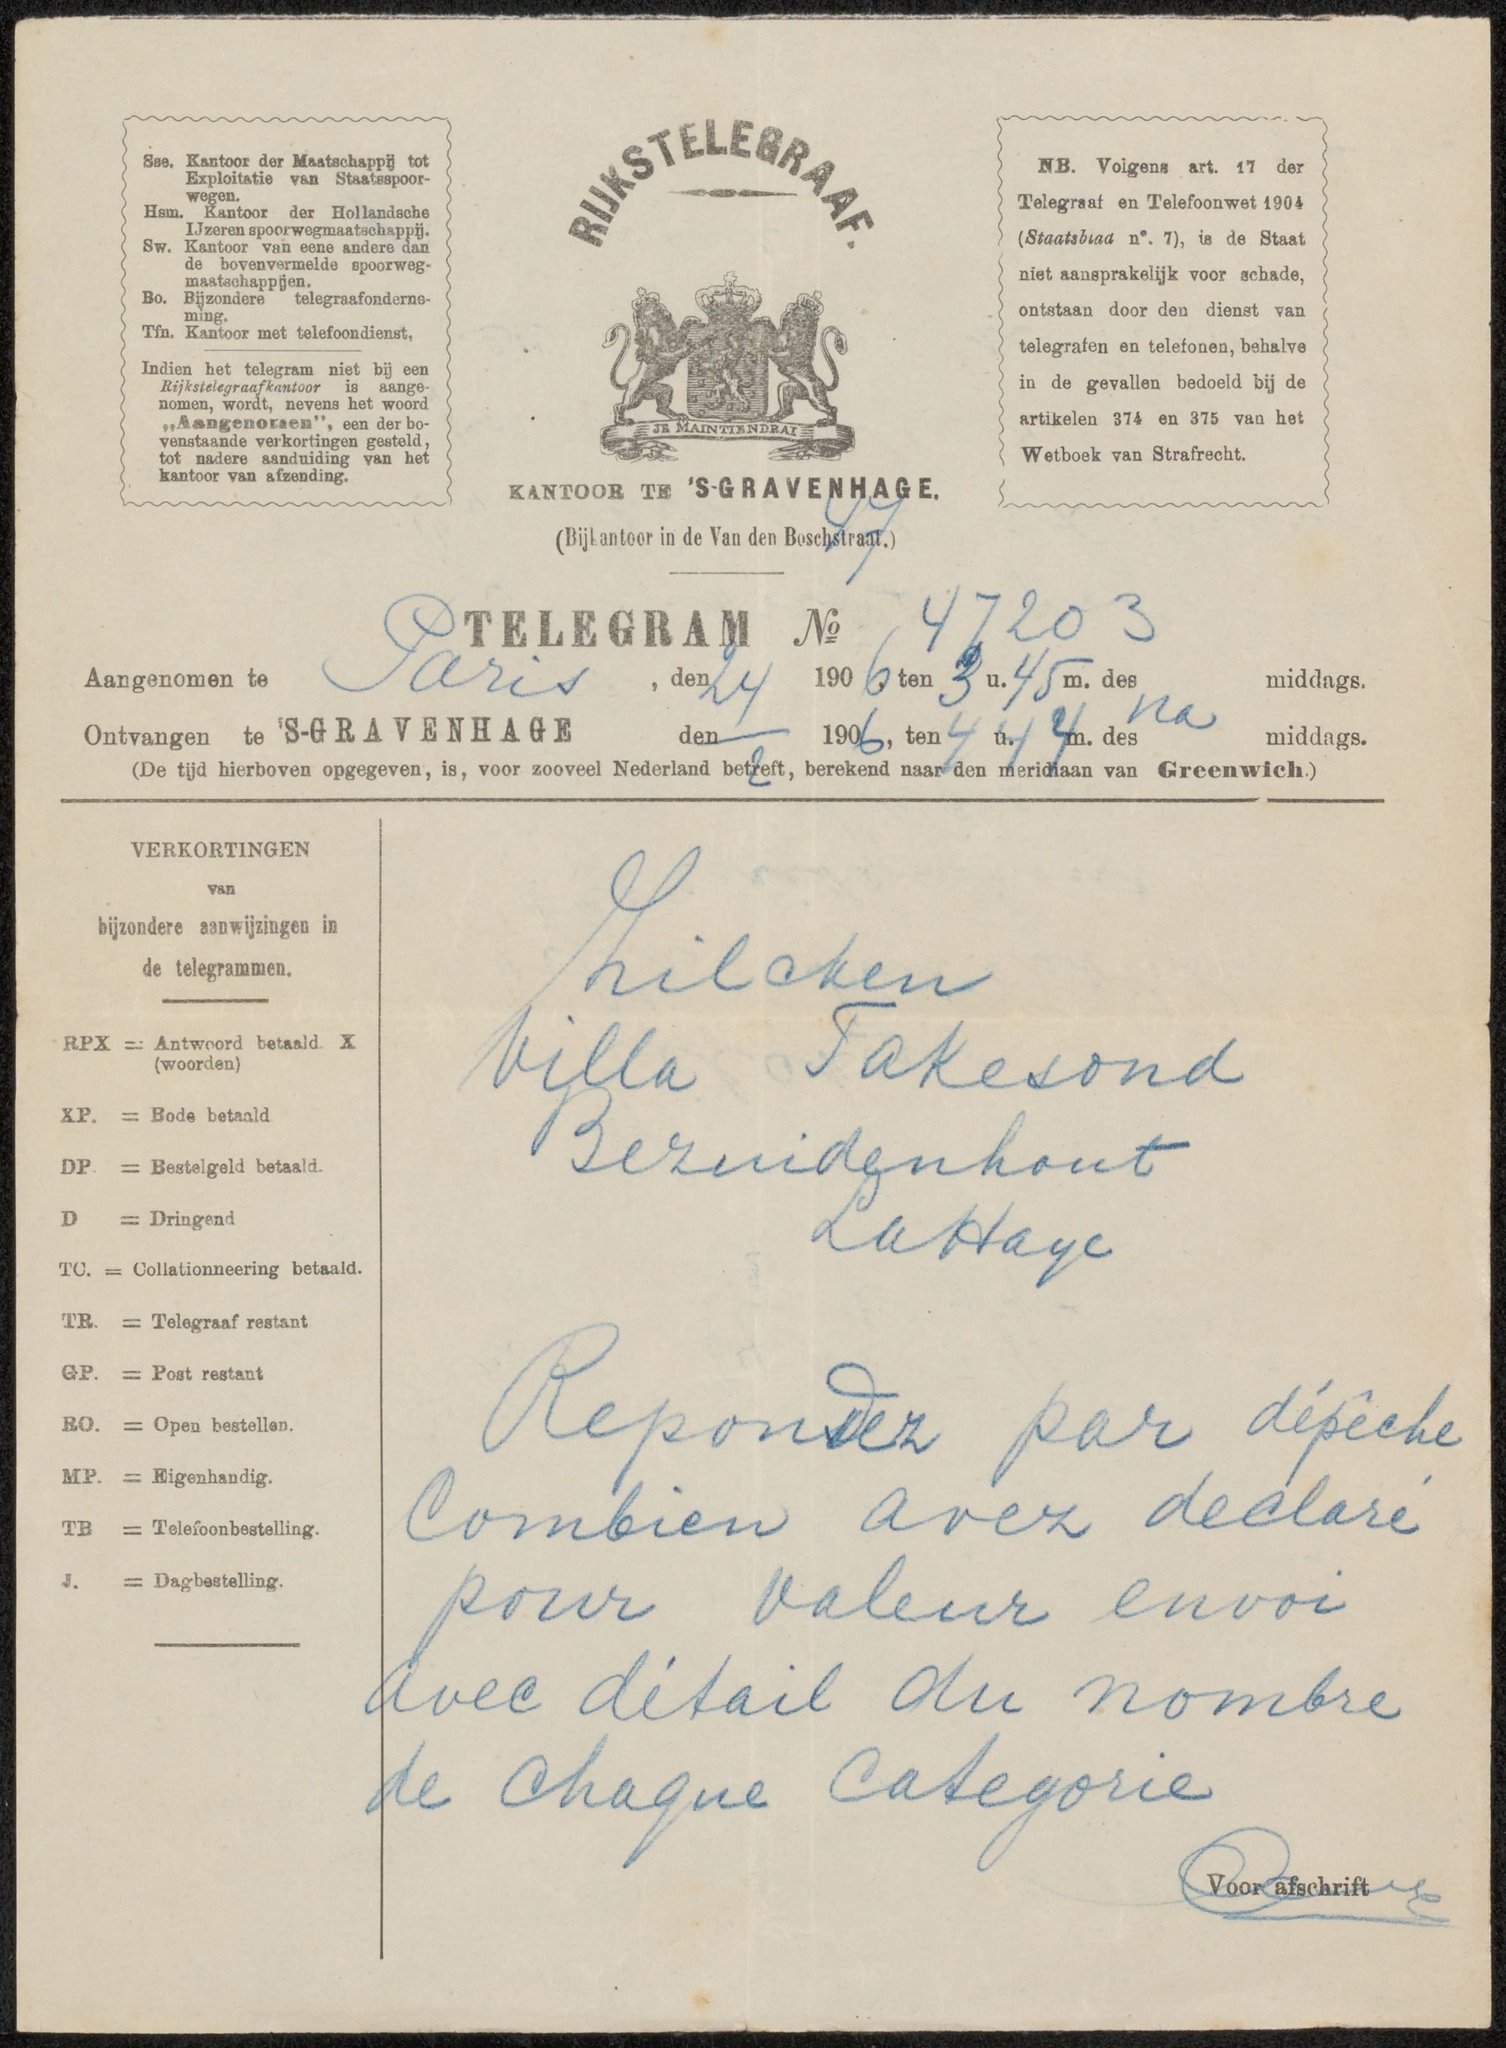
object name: telegram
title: Telegram aan Philip Zilcken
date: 1906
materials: paper, pencil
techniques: printing, writing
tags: the hague, painter, draughtsman, philip zilcken, drawing, sending and receiving postal matter, the graphic arts, painting (including book-illumination, miniature-painting)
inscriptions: collector's mark: ‘RPK’